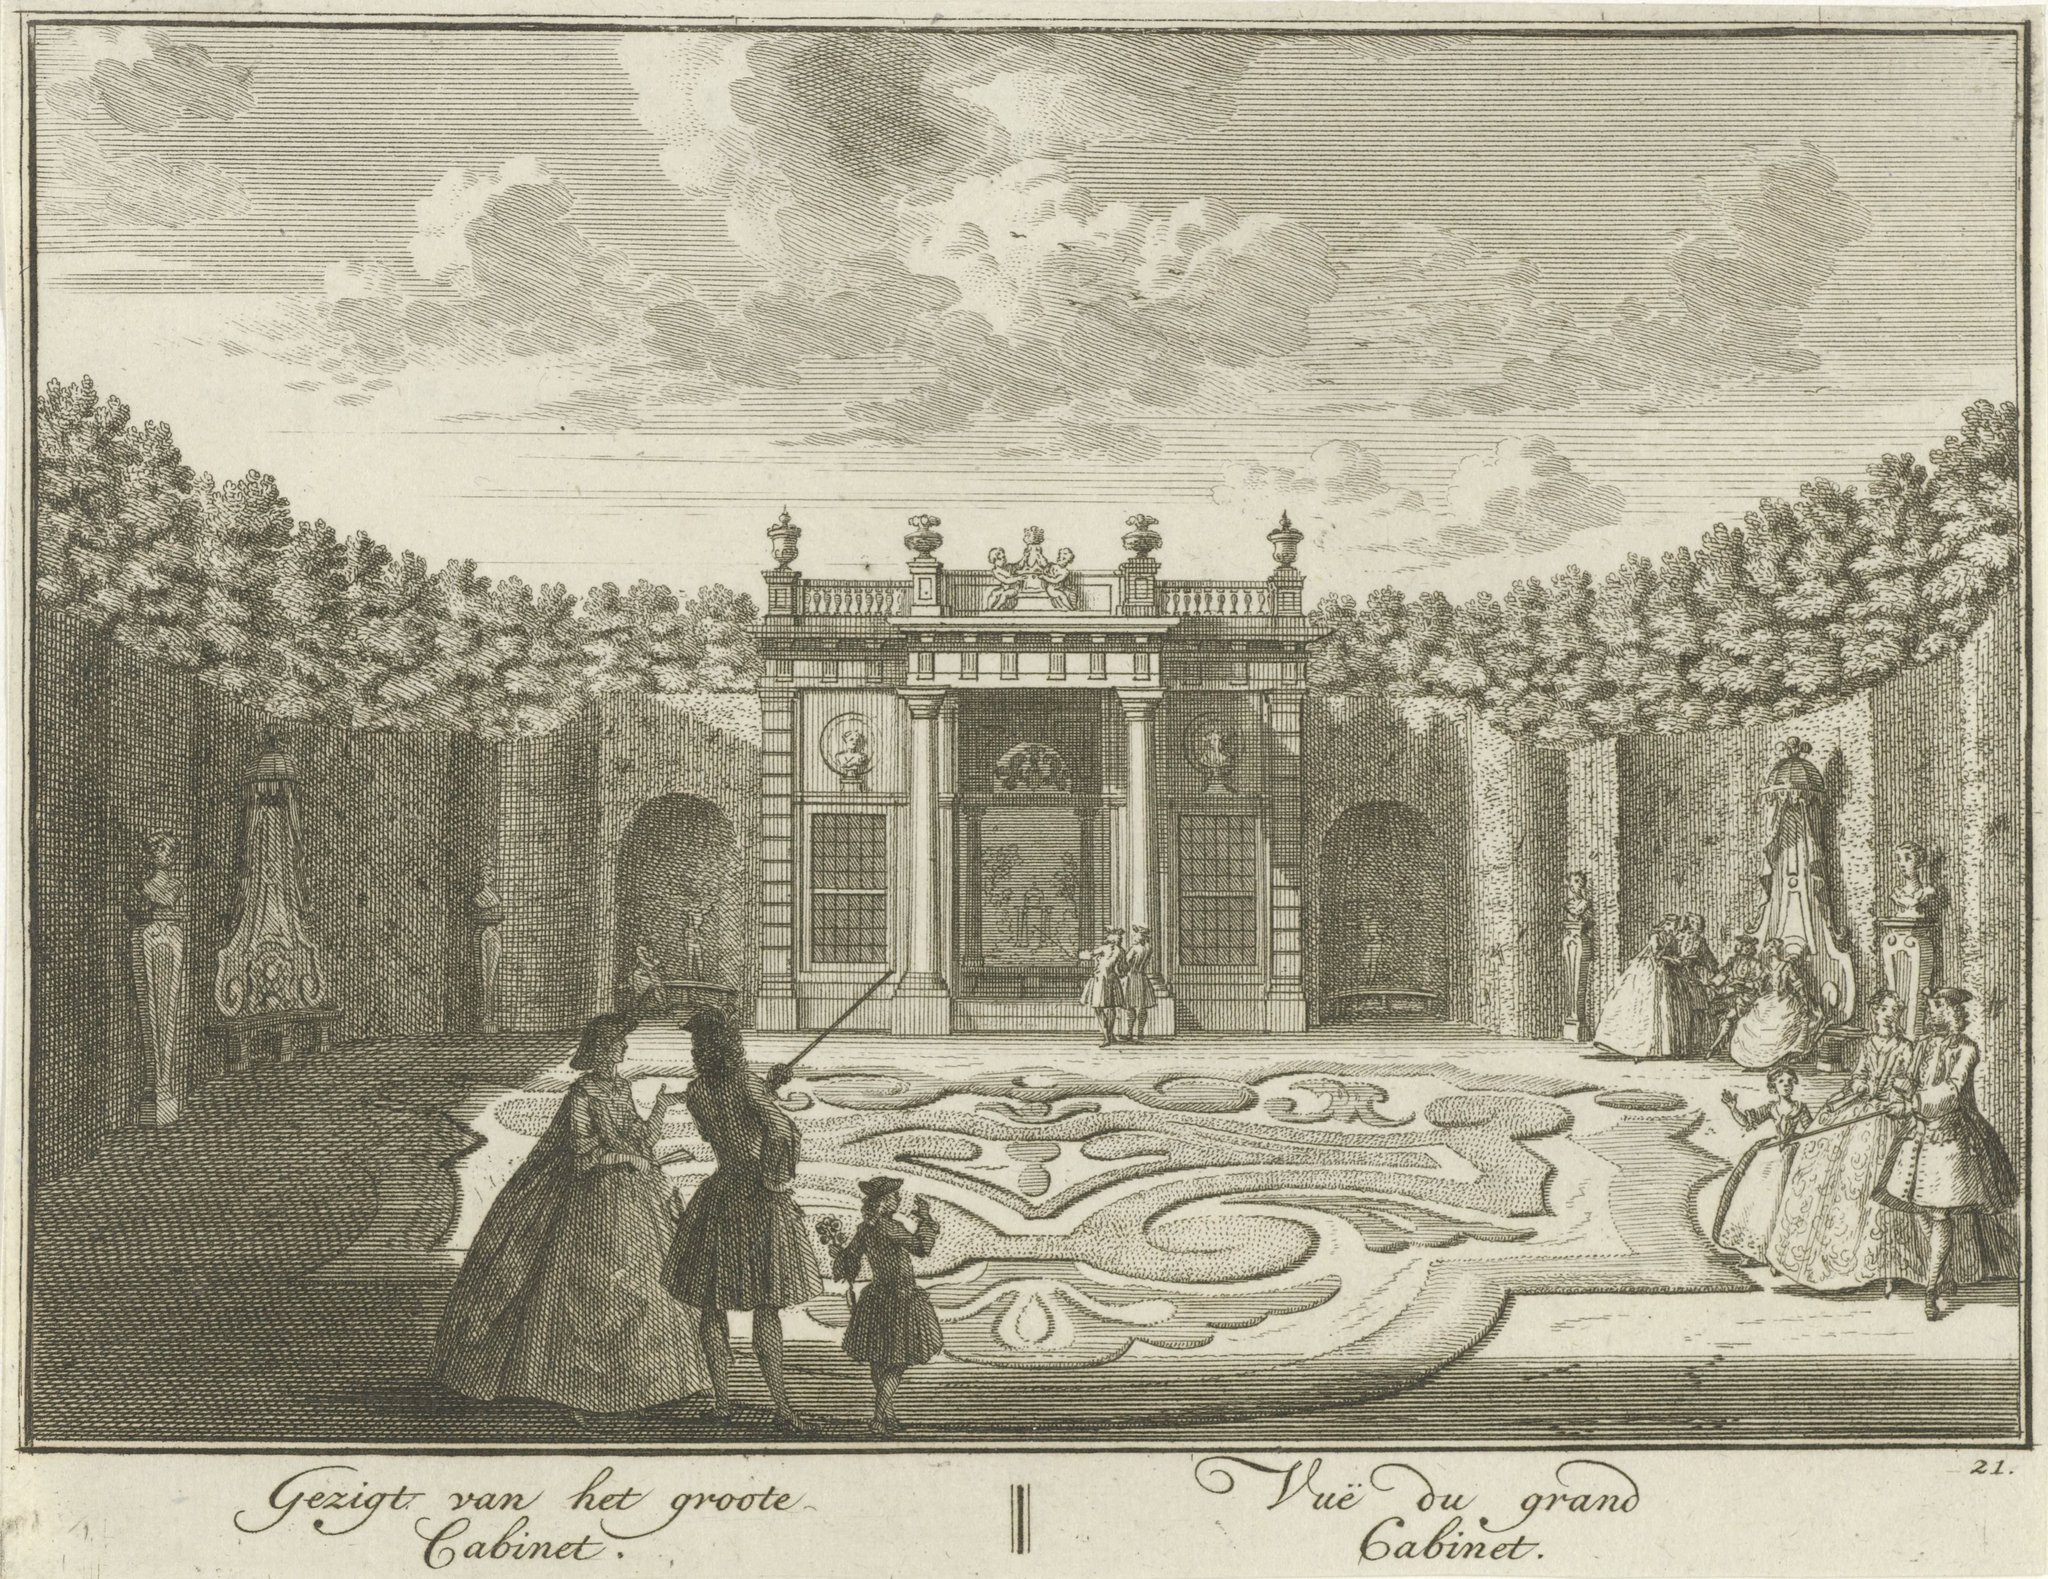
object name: print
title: Gezigt van het groote Cabinet / Vue du grand Cabinet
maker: hendrik de leth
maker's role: draughtsman, print maker, publisher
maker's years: 1703-1766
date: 1740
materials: paper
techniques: etching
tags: french or architectonic garden; formal garden, country-house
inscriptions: collector's mark: Lugt 2228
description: Gezicht op het kabinet in de Franse tuin van Huis ter Meer. In de tuin wandelen groepjes figuren. De prent maakt deel uit van een serie met 26 gezichten op Huis ter Meer en het bijbehorende landgoed te Maarssen.